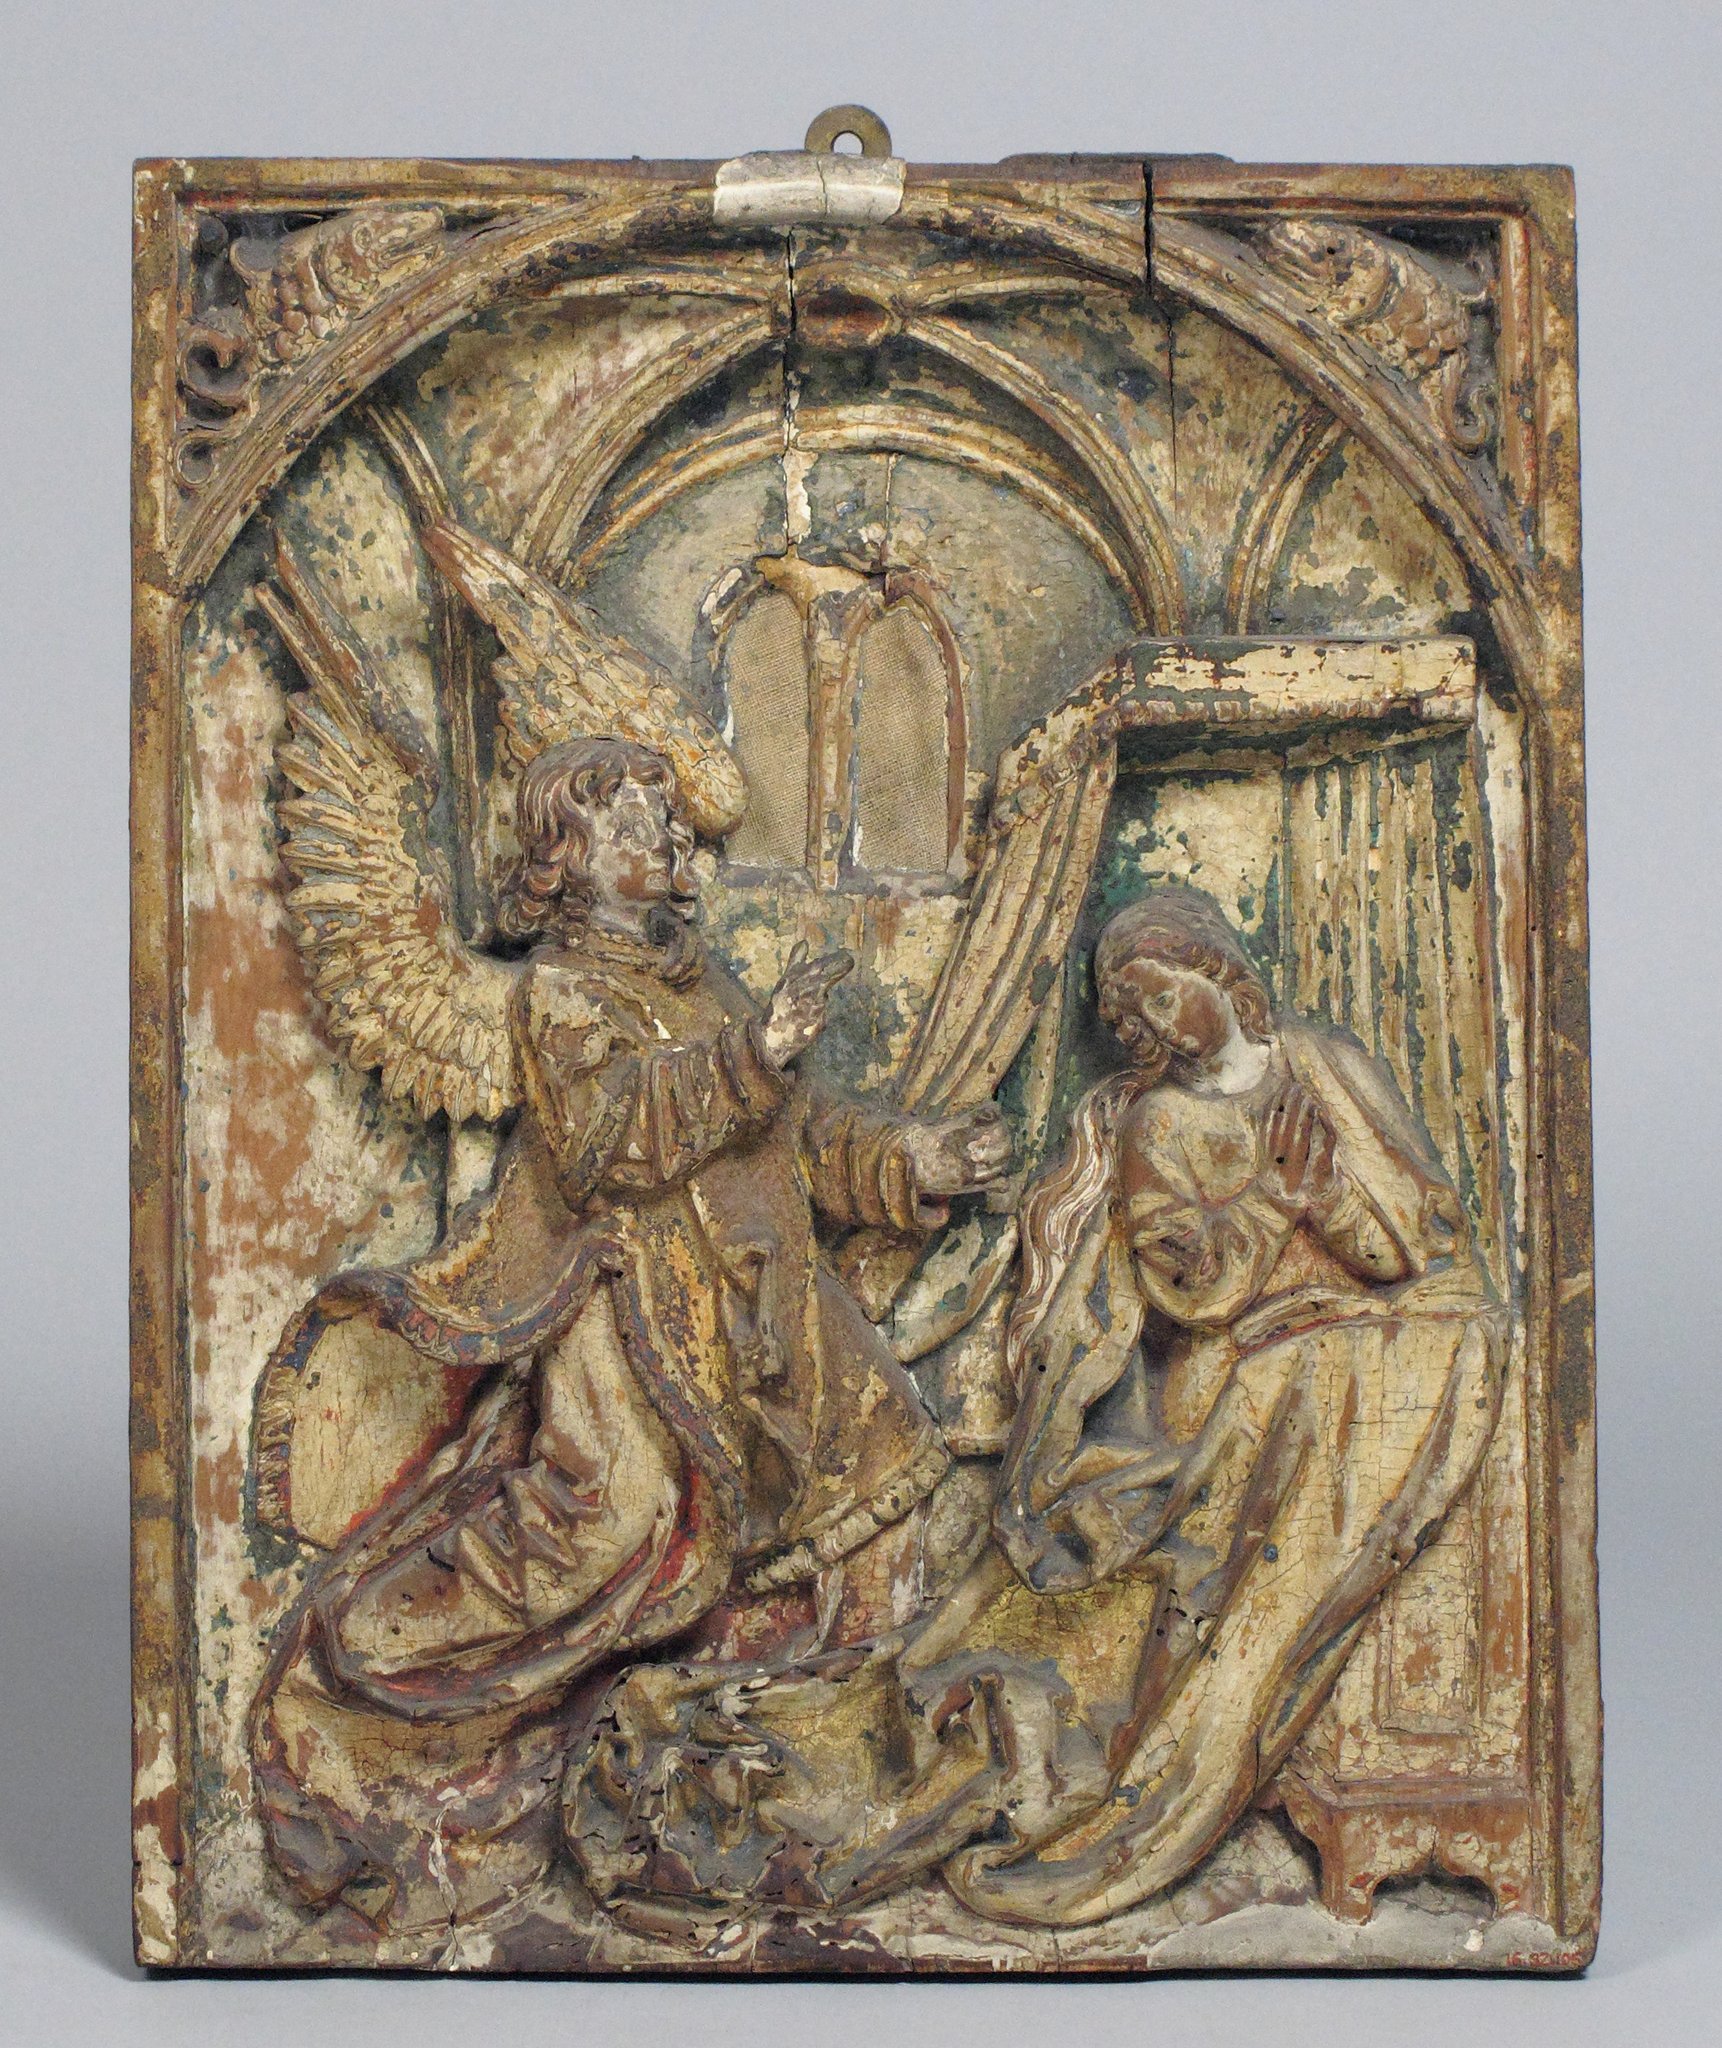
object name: relief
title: The Annunciation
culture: german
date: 1501-1600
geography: germany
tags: angels,virgin mary